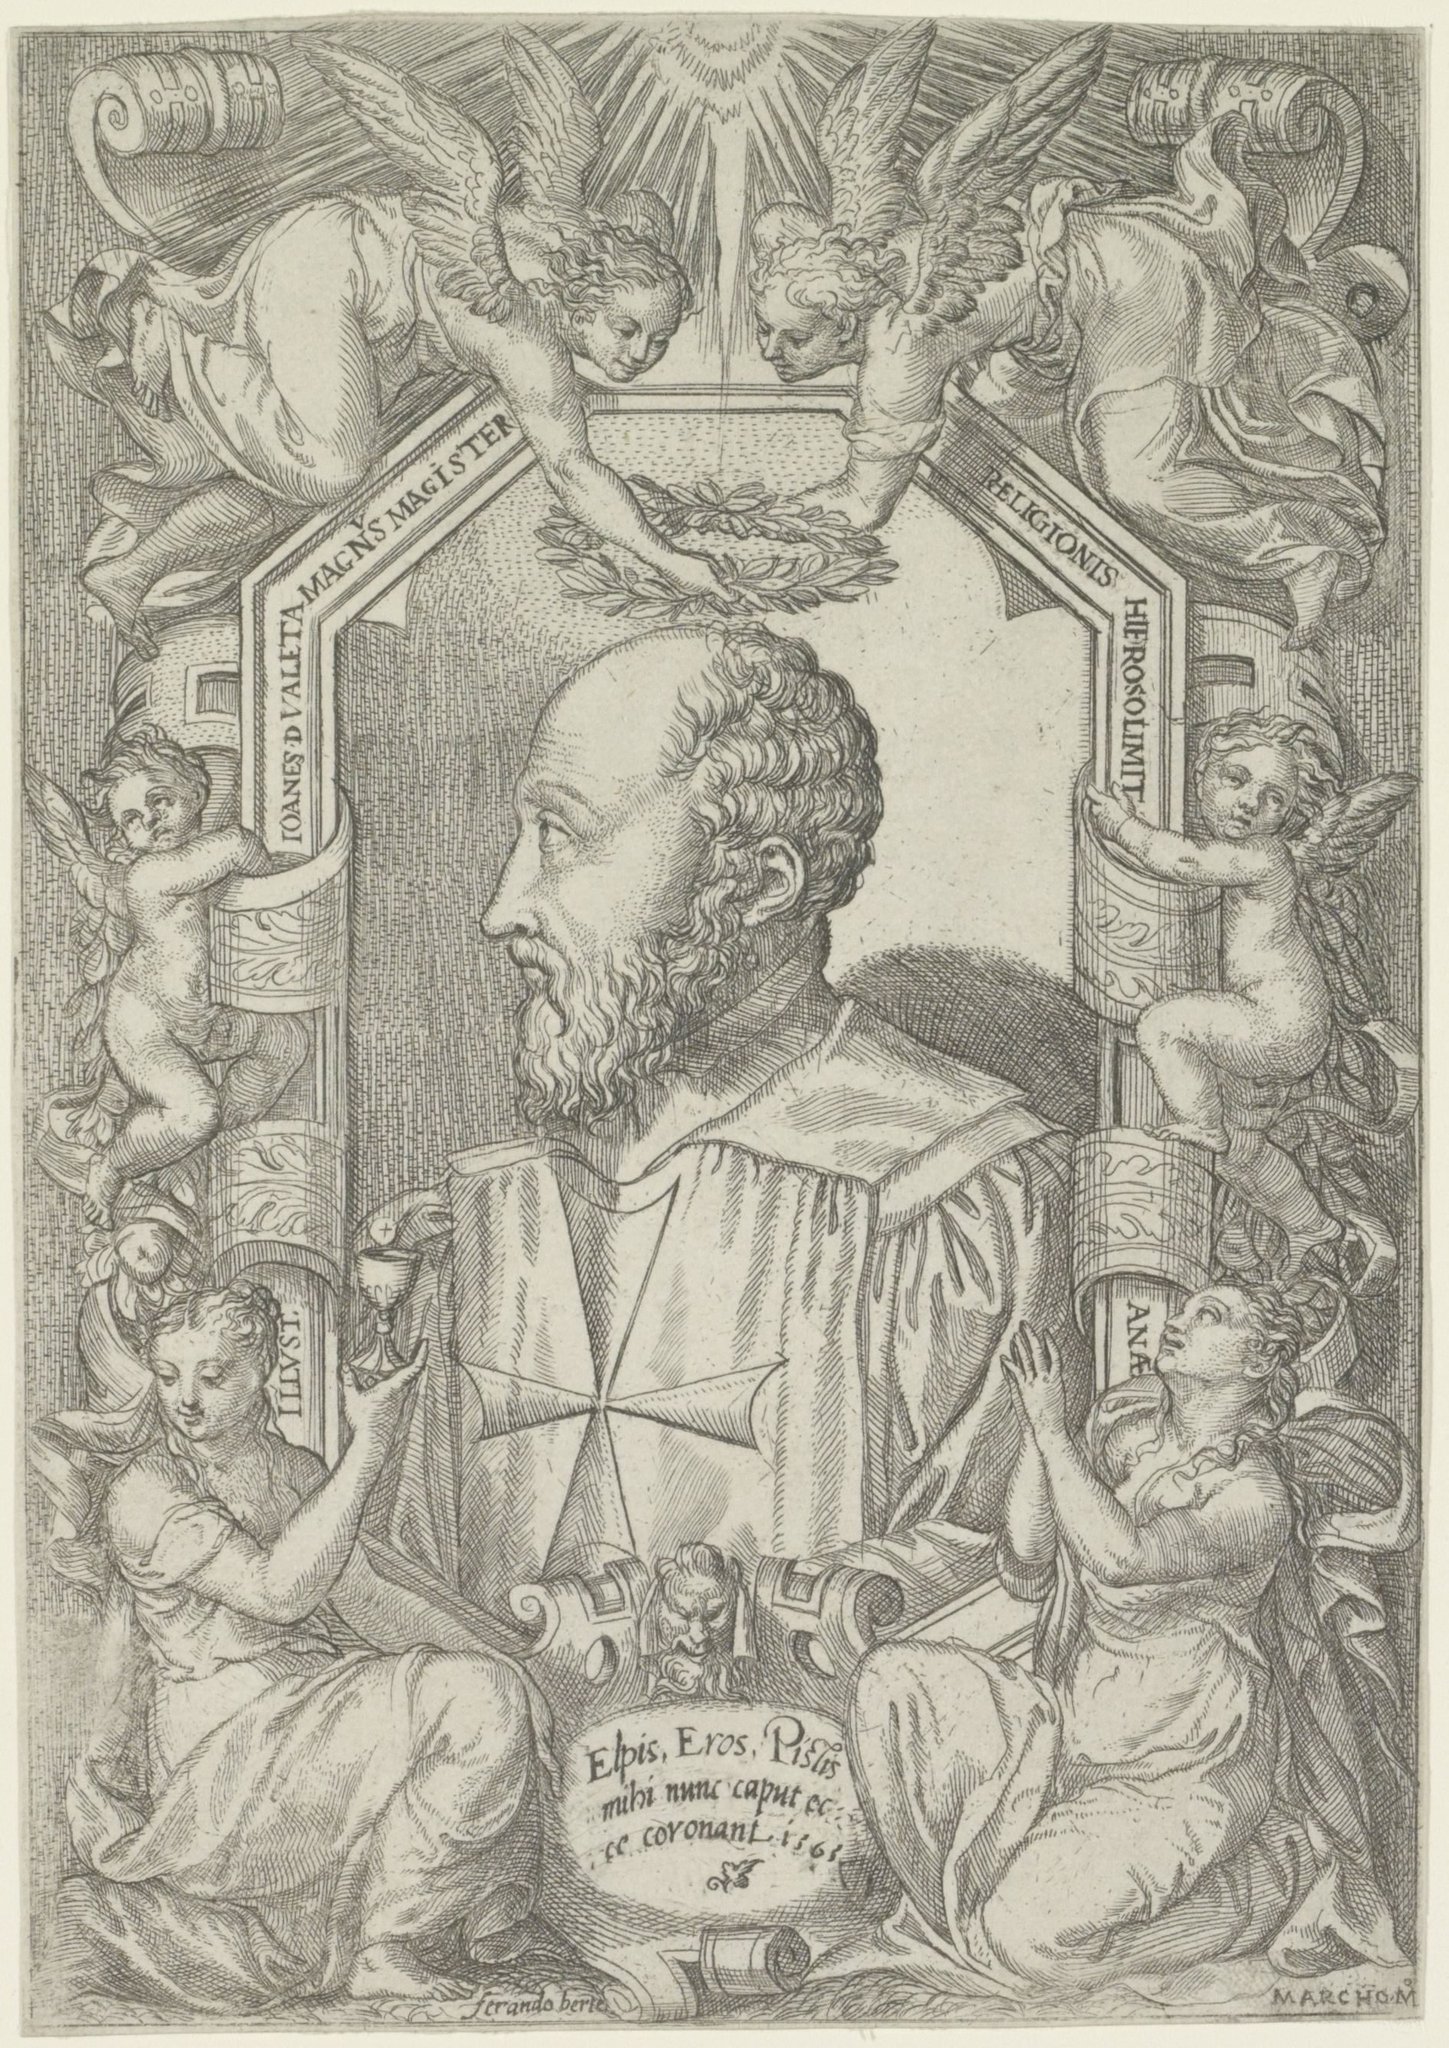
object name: print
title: Portret van Jean Parisot de La Valette, grootmeester van de Orde van Malta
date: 1565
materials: paper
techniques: etching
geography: italy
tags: historical persons, cupids: 'amores', 'amoretti', 'putti', angels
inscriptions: collector's mark: Lugt 2228